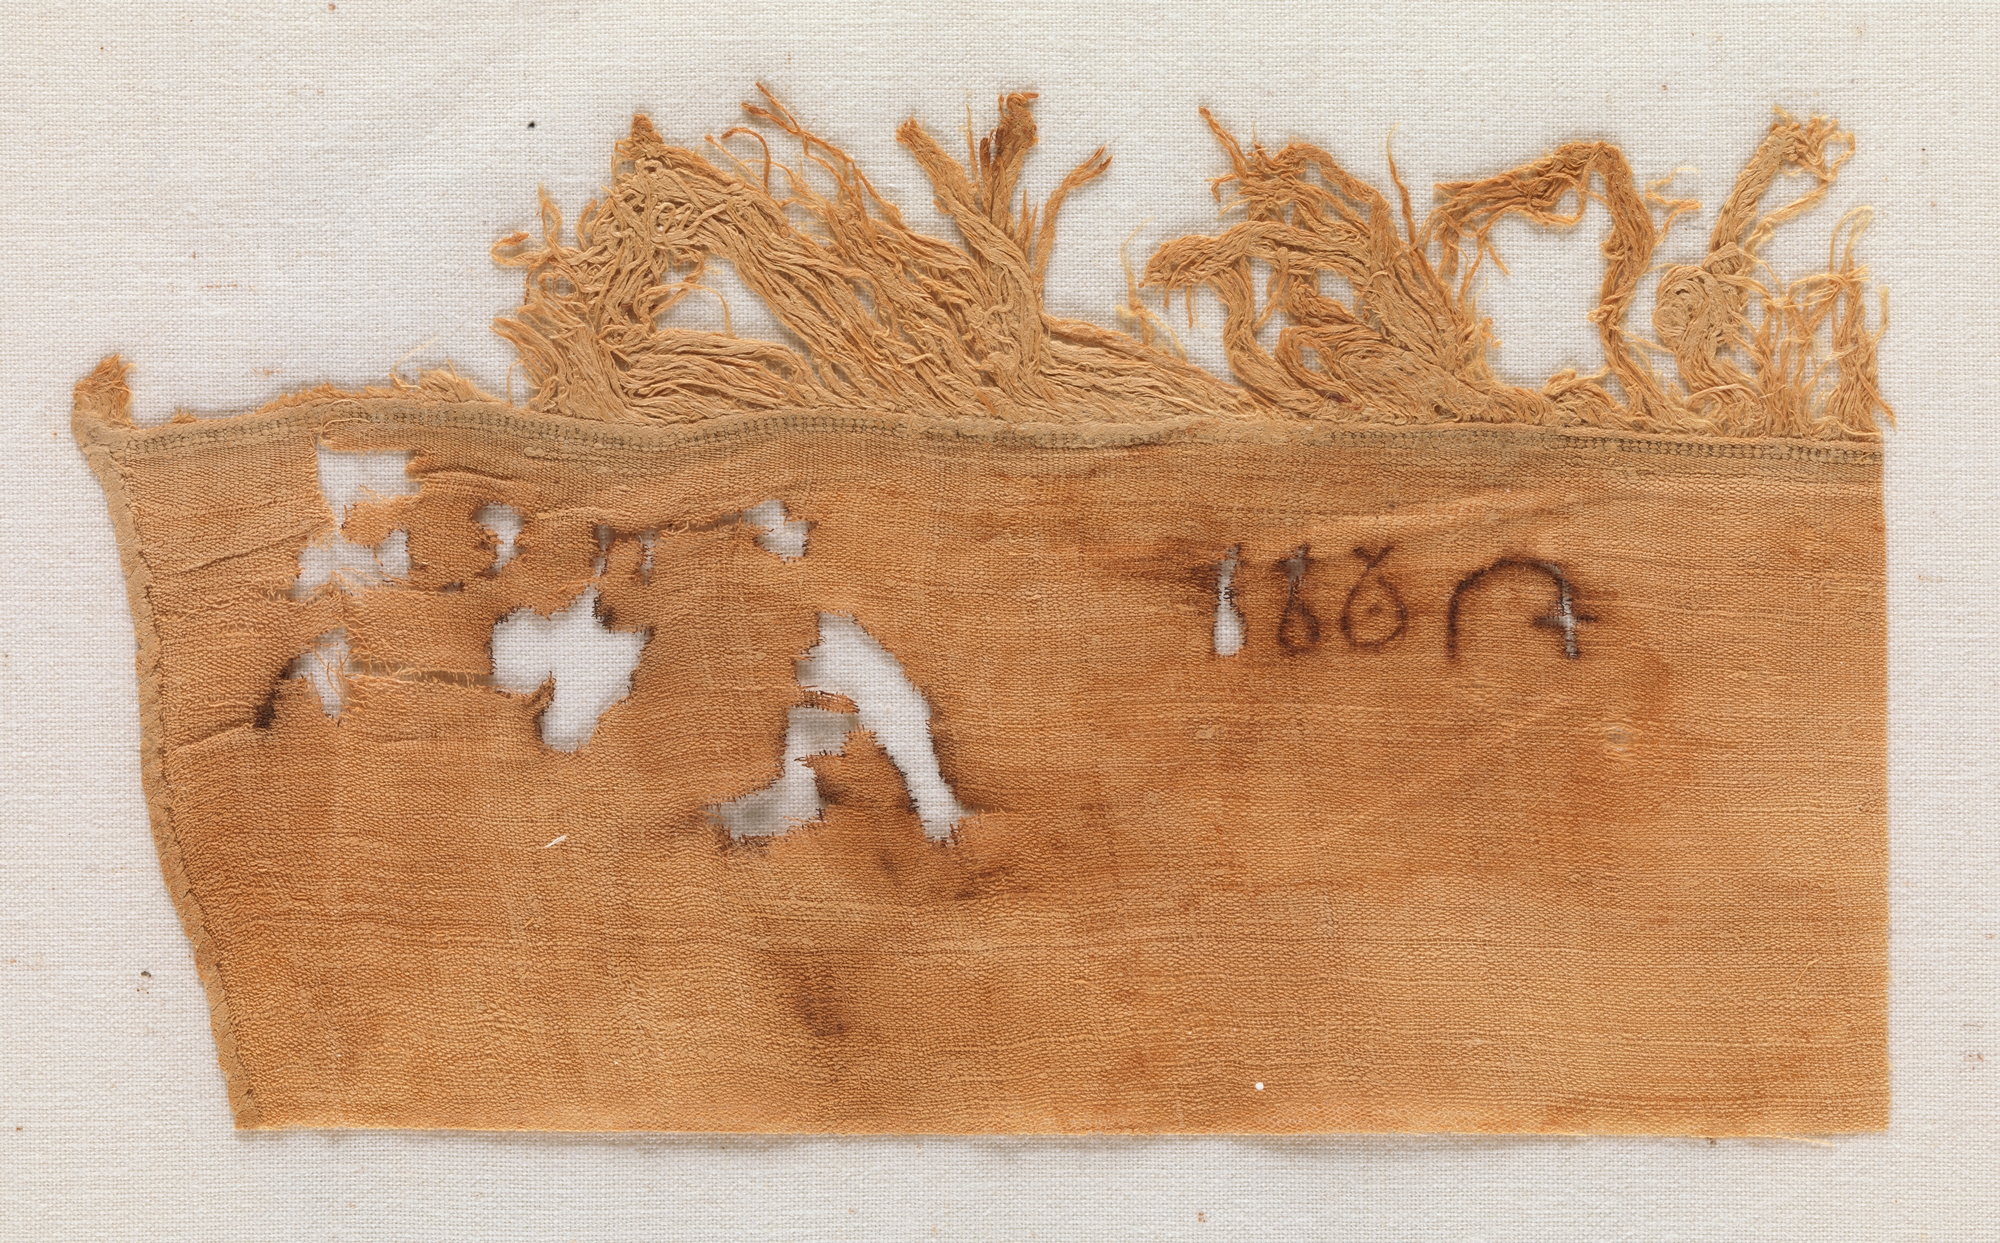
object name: linen mark, mummy of henhenet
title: Linen marks from the wrappings of Henhenet's mummy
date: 2051-2030 BCE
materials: linen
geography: egypt